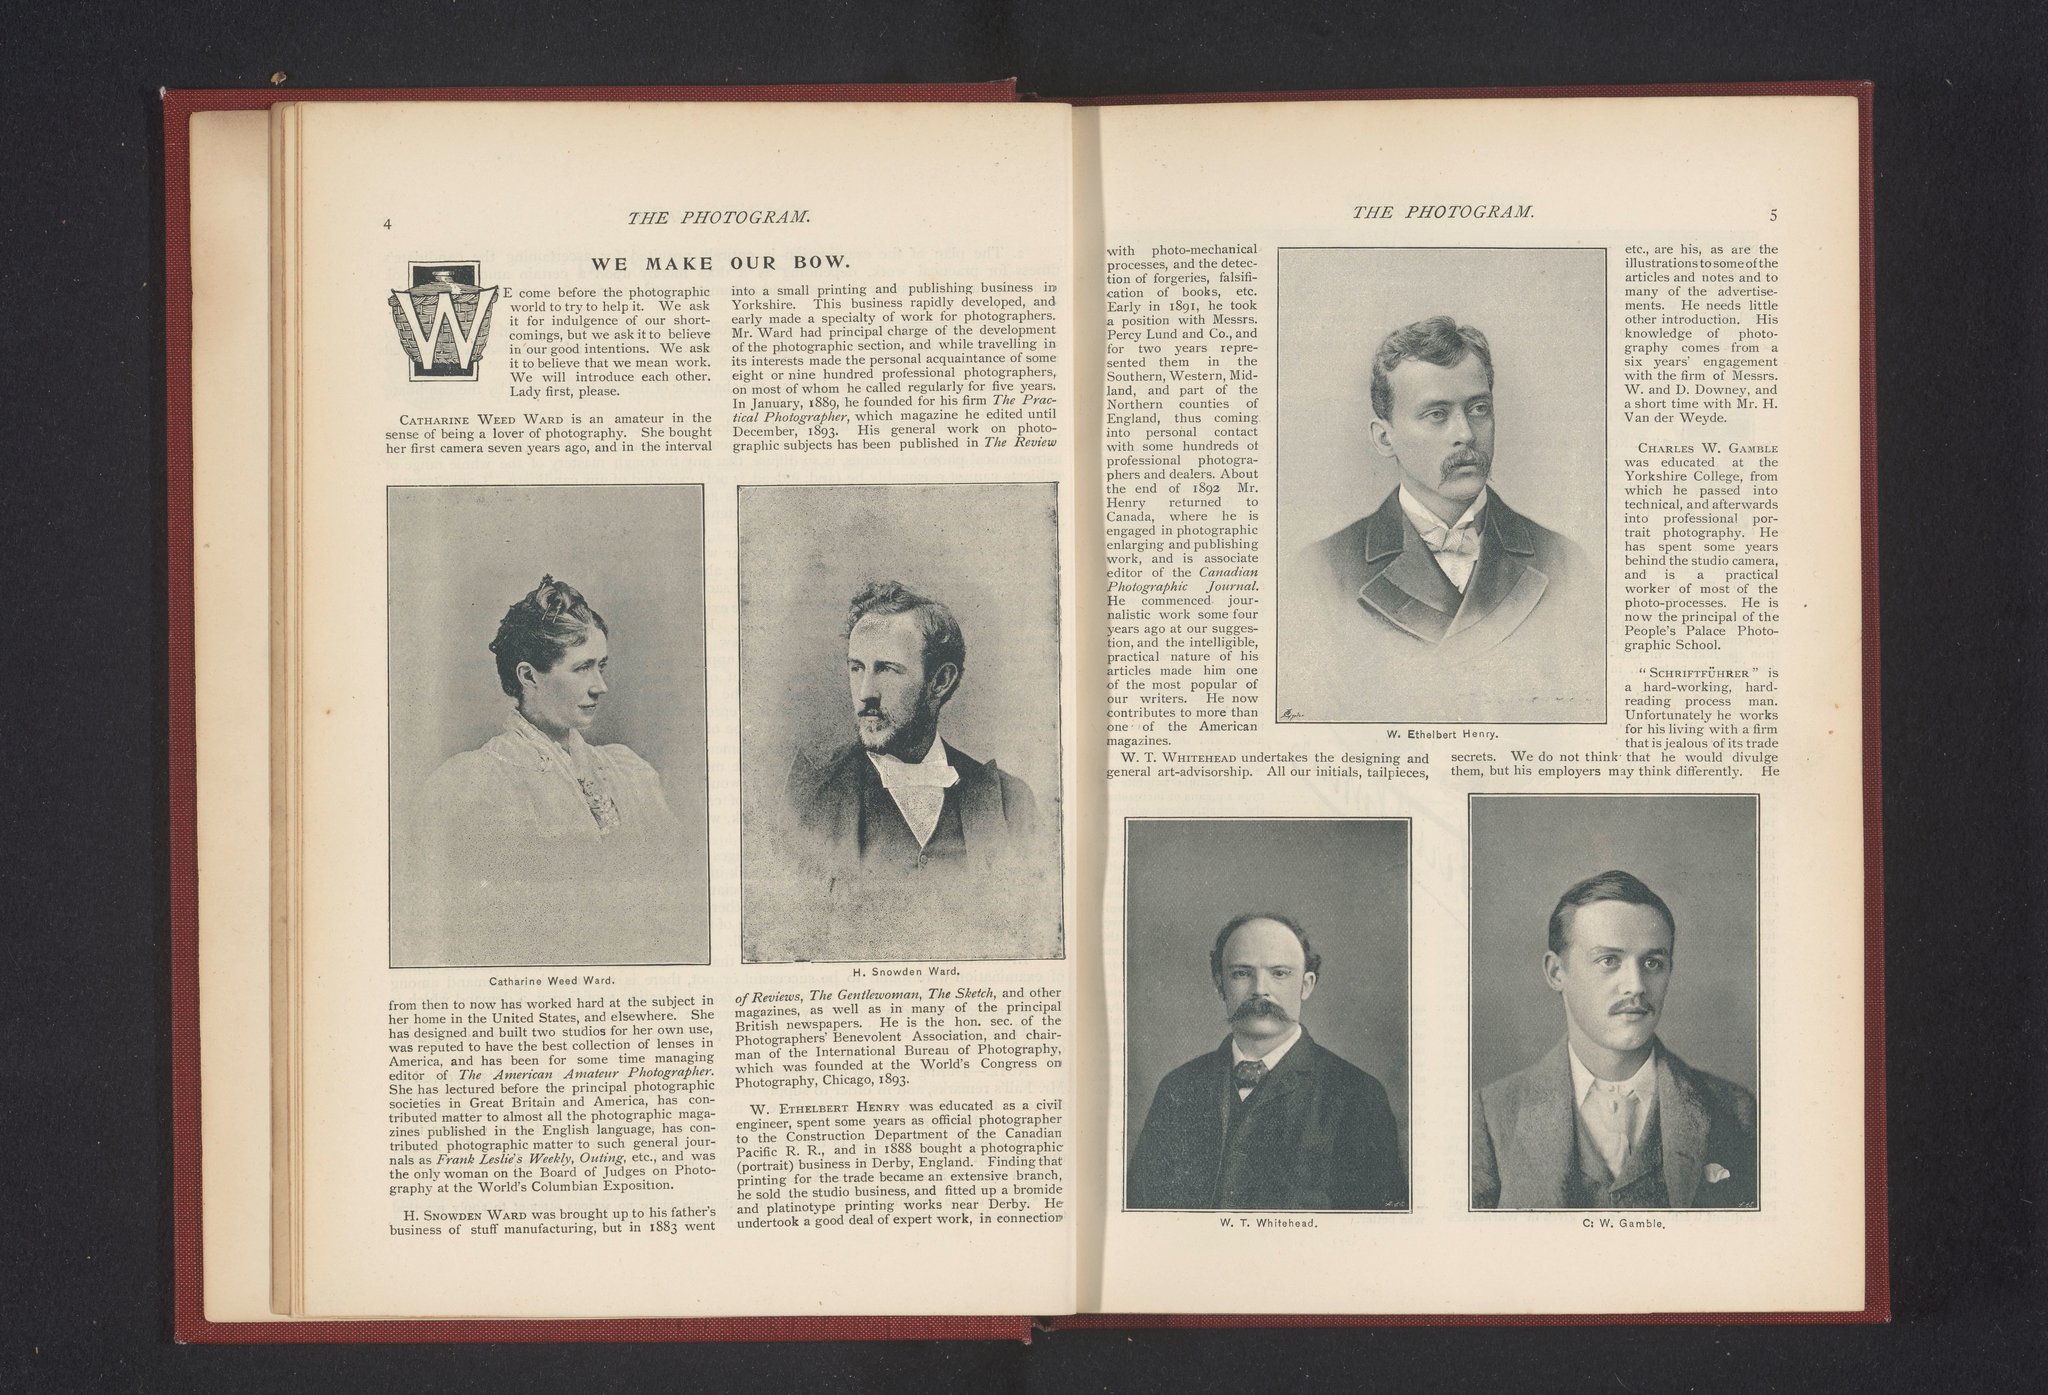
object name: page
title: Portret van W. Ethelbert Henry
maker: Anonymous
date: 1889-1894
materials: paper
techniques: autotype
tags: historical persons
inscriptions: monogram: ‘[...]’